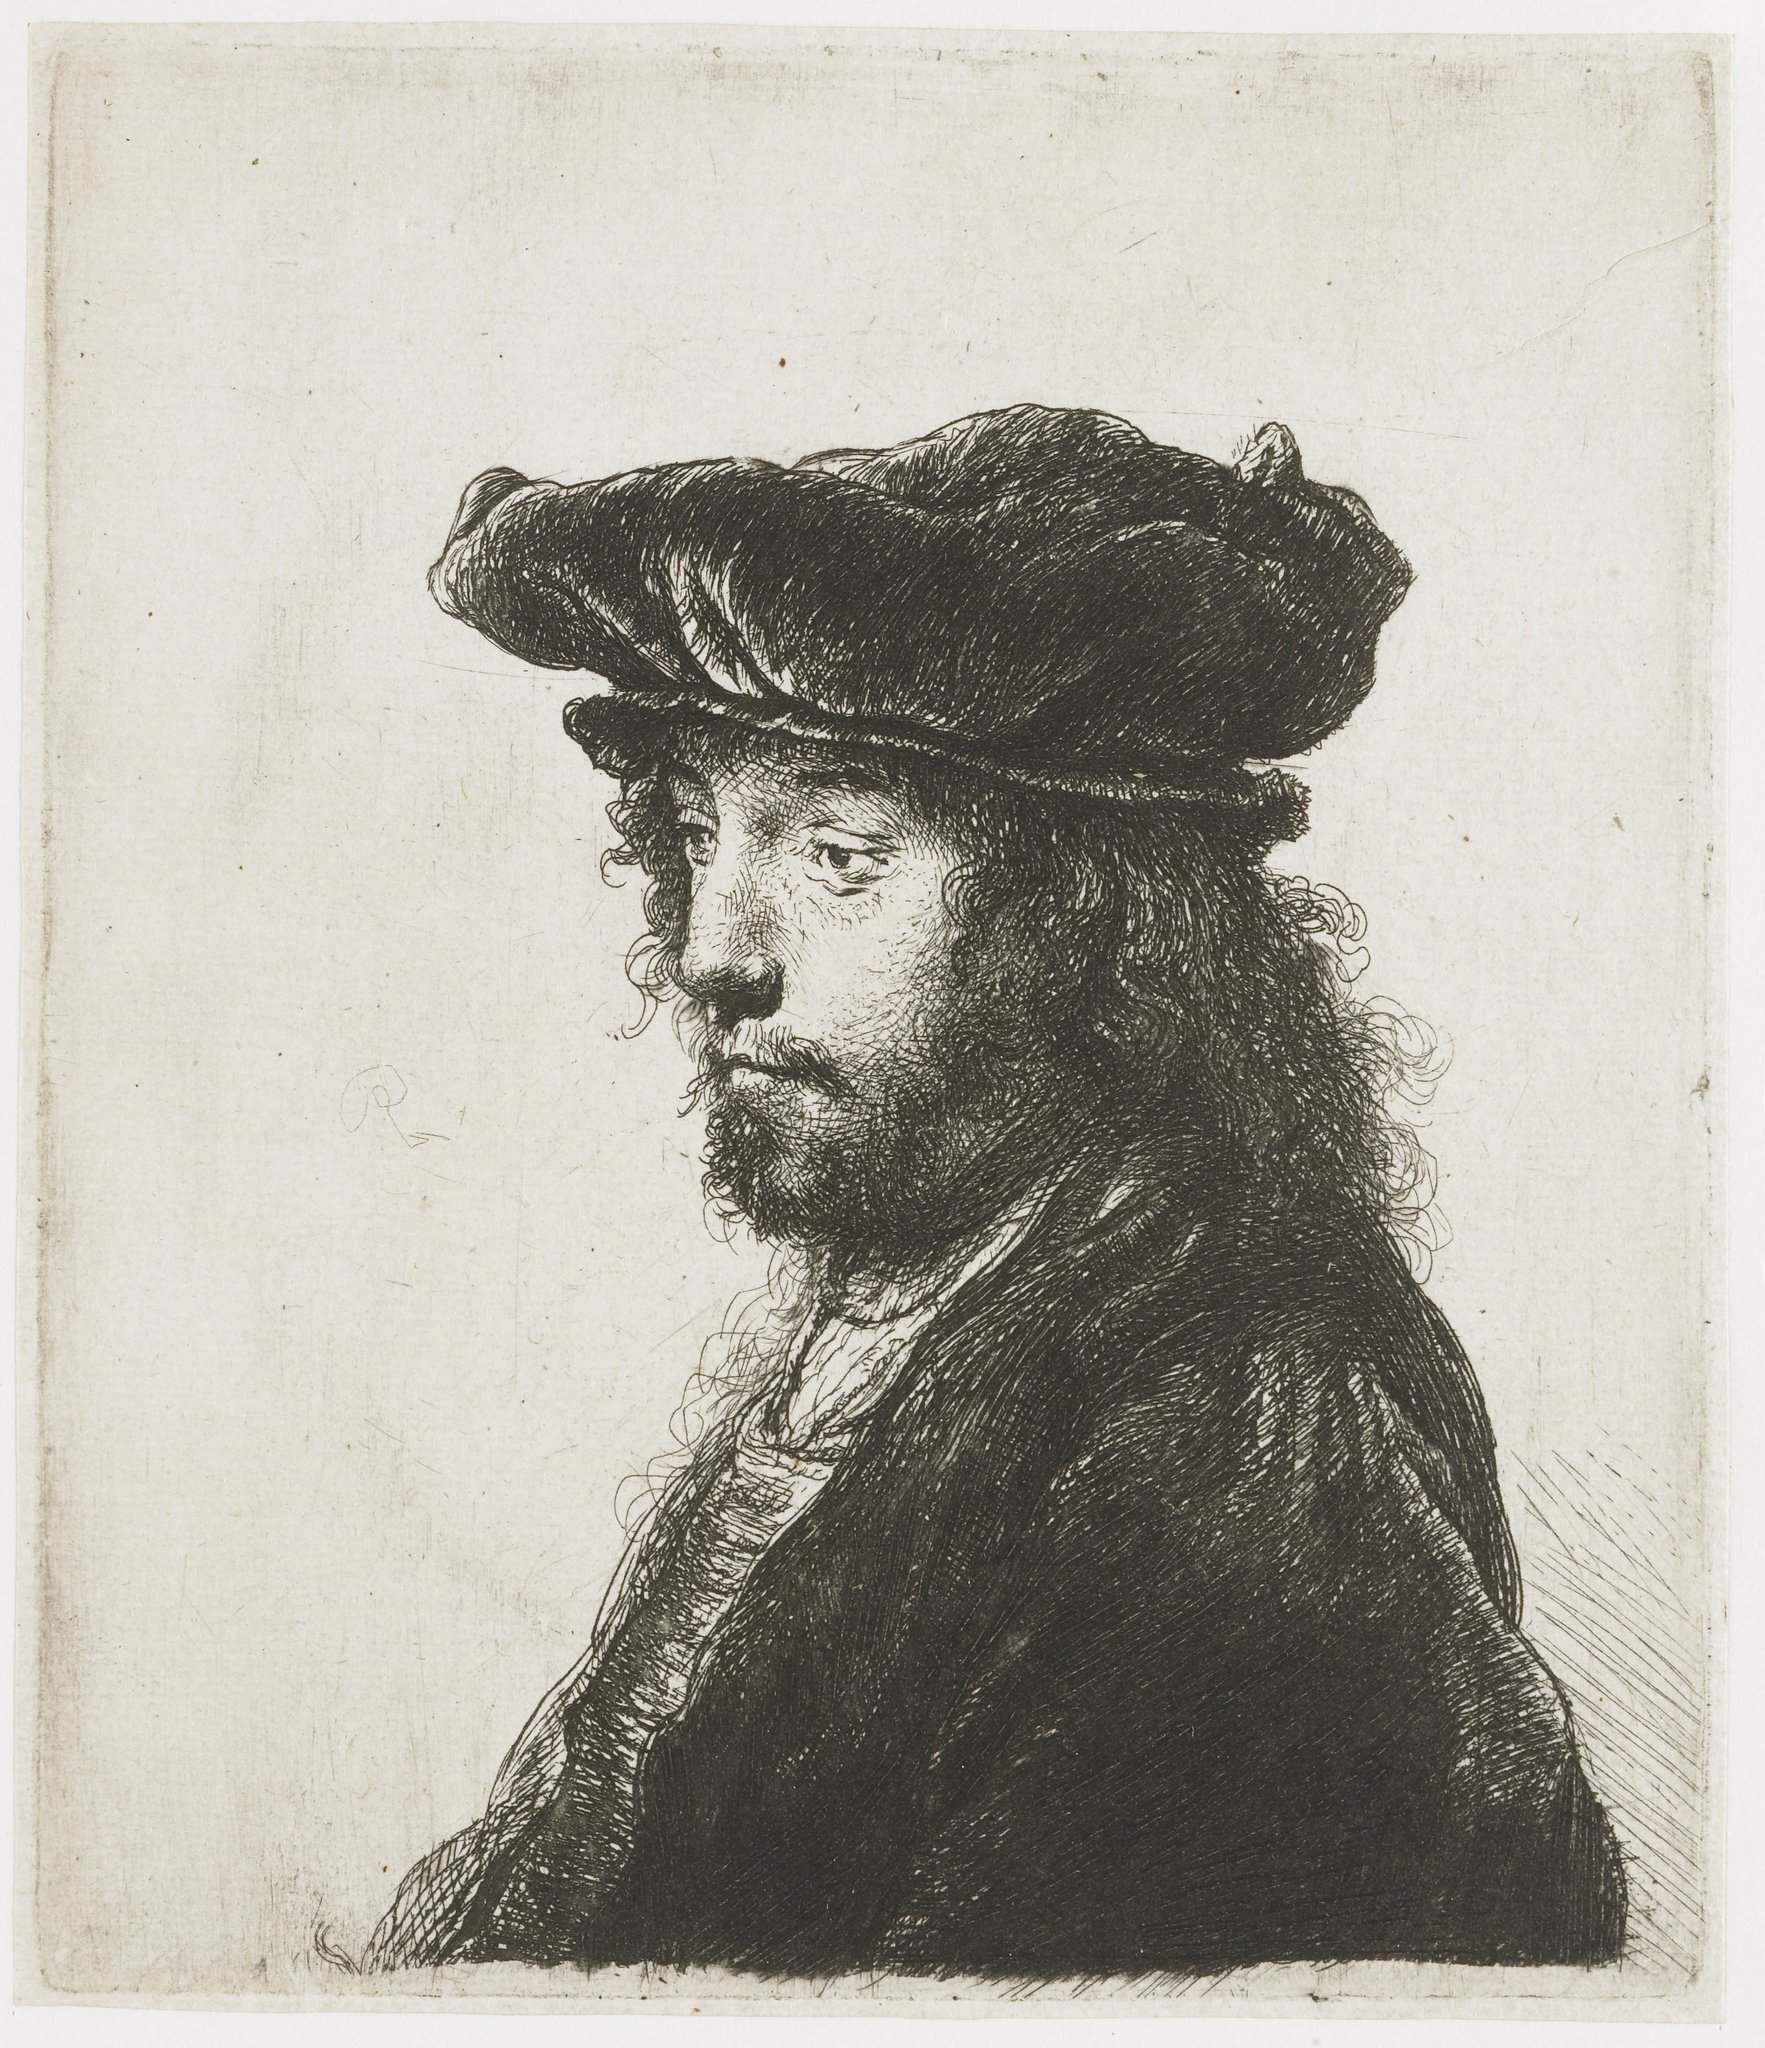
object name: print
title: The Fourth Oriental Head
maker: rembrandt van rijn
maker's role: draughtsman, painter, print maker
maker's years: 1606-1669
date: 1635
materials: paper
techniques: etching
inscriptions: monogram: ‘Rt’, mark: Lugt 2228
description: This set of etchings is traditionally called the ‘Four Oriental Heads’. Rembrandt did not etch them from life, but rather after prints his Leiden friend and colleague Jan Lievens made around 1631. He did not do this simply because he admired Lievens’s work. On three of the four prints, Rembrandt noted that he had geretuckeerd (meaning both adapted and improved) them.